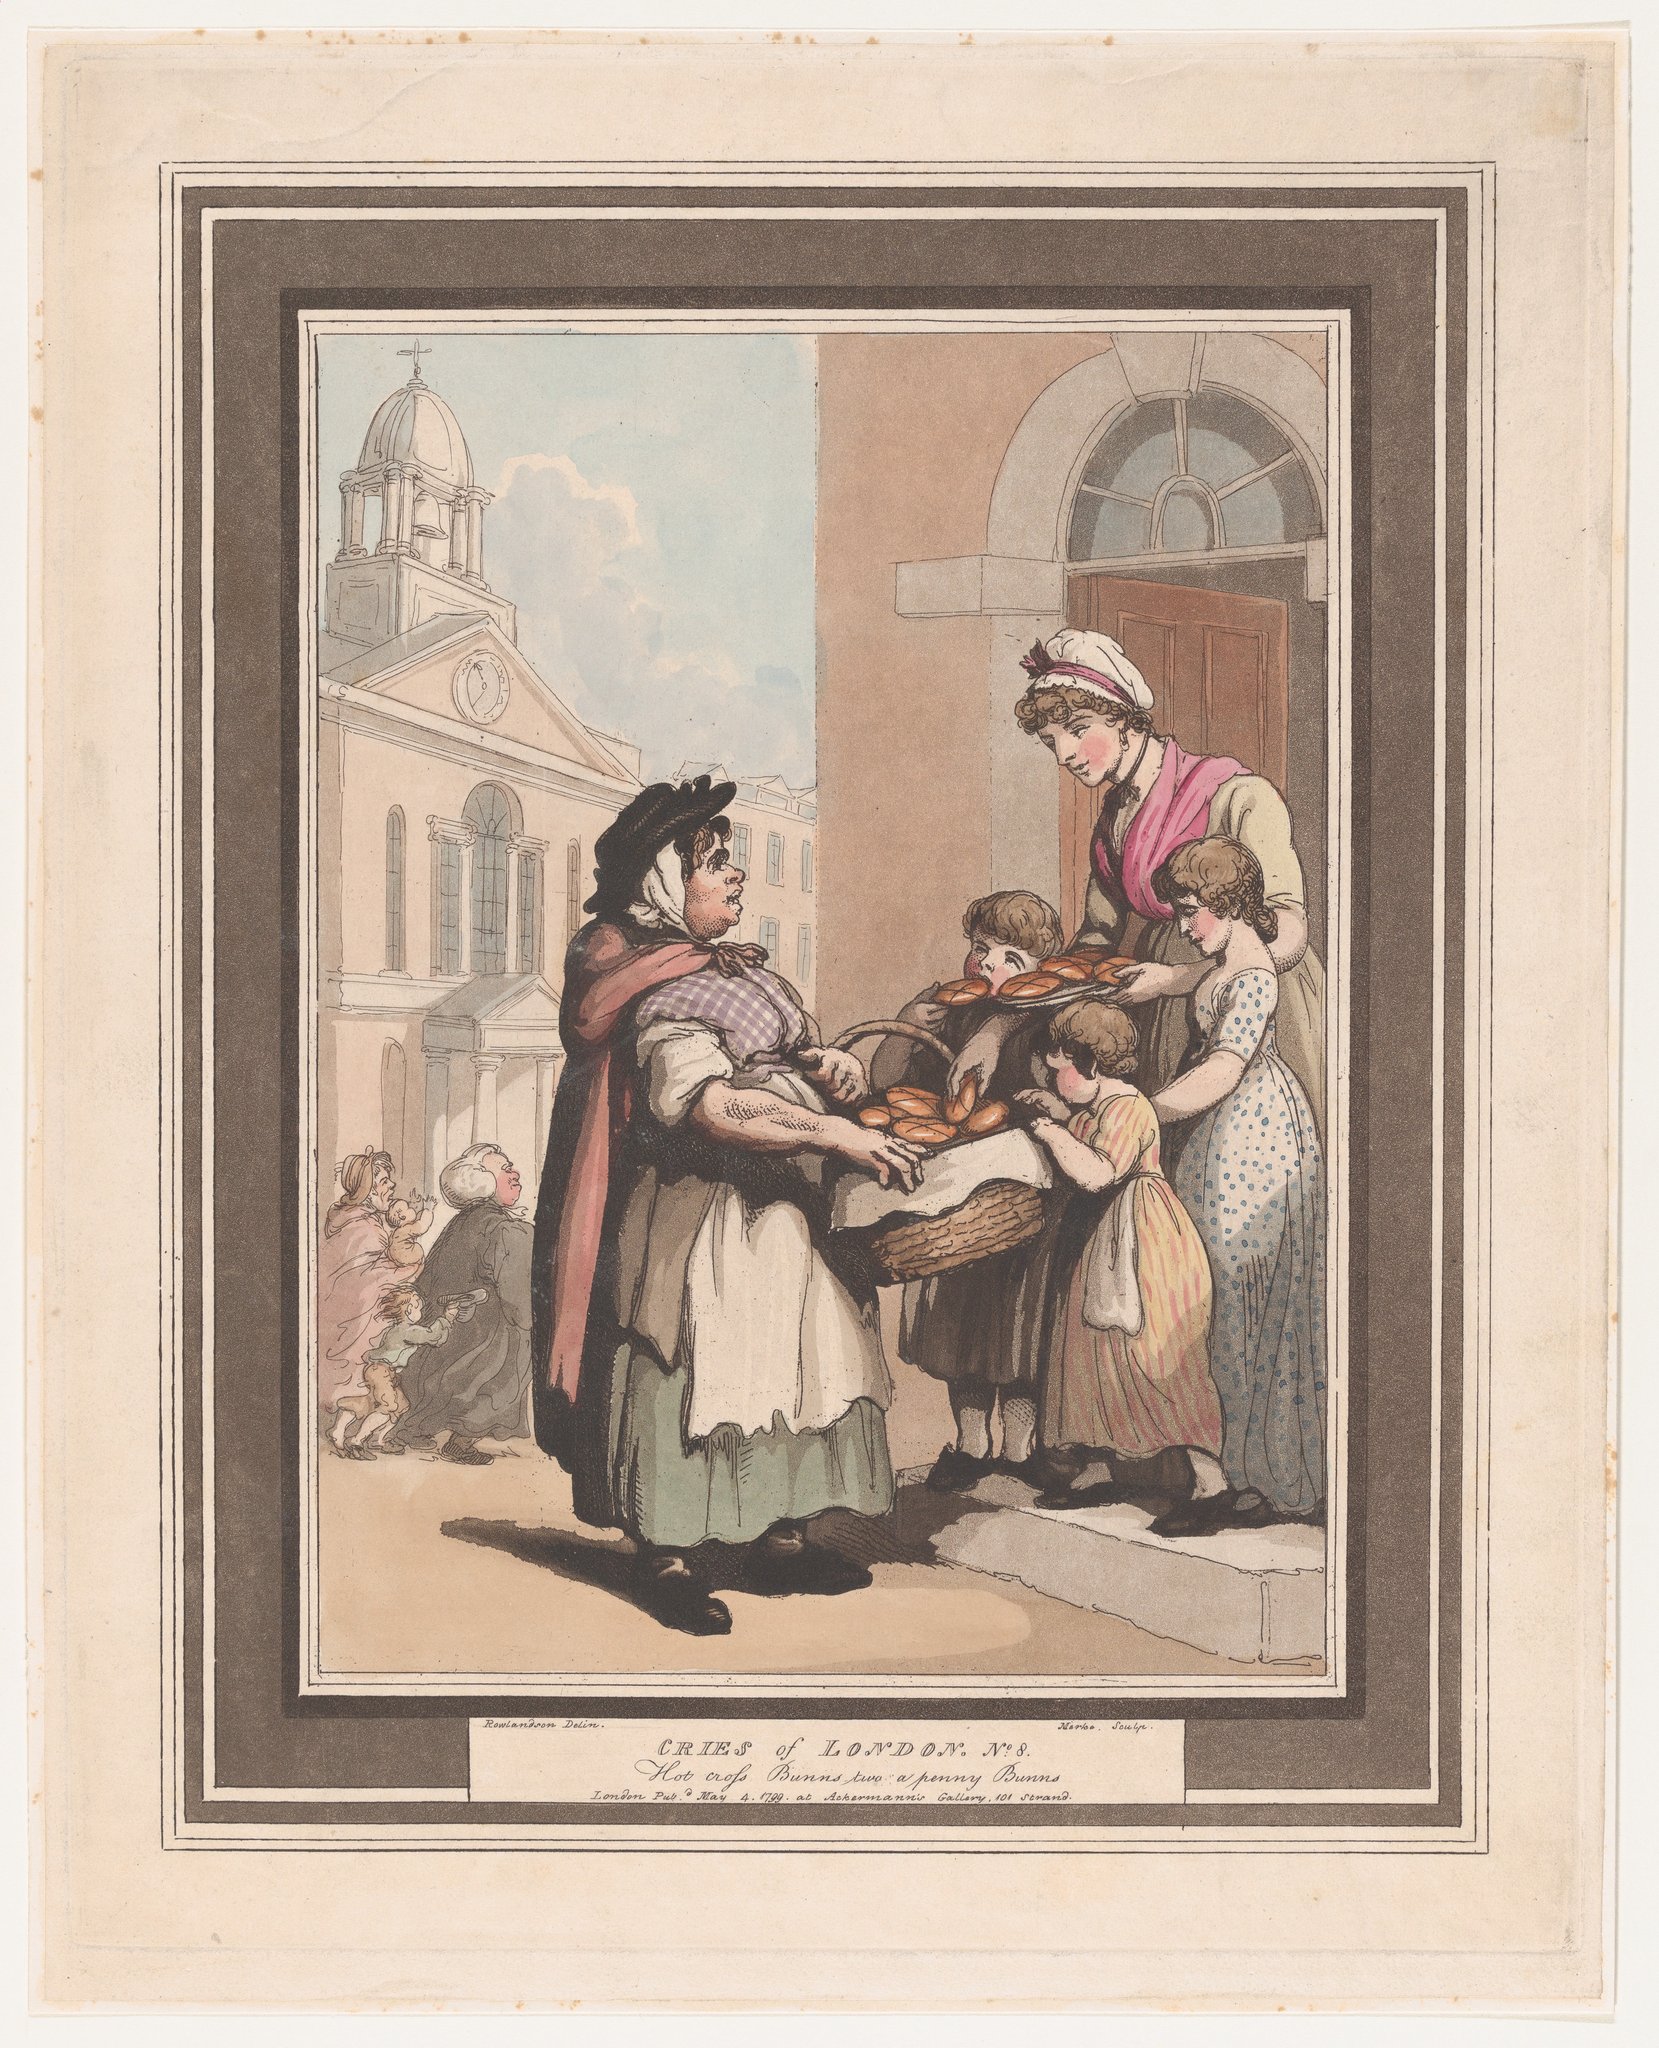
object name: print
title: Cries of London, No. 8: Hot Cross Buns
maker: henri merke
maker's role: artist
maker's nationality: swiss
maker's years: 1760-1820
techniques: aquatint, etching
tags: food,boys,girls,women